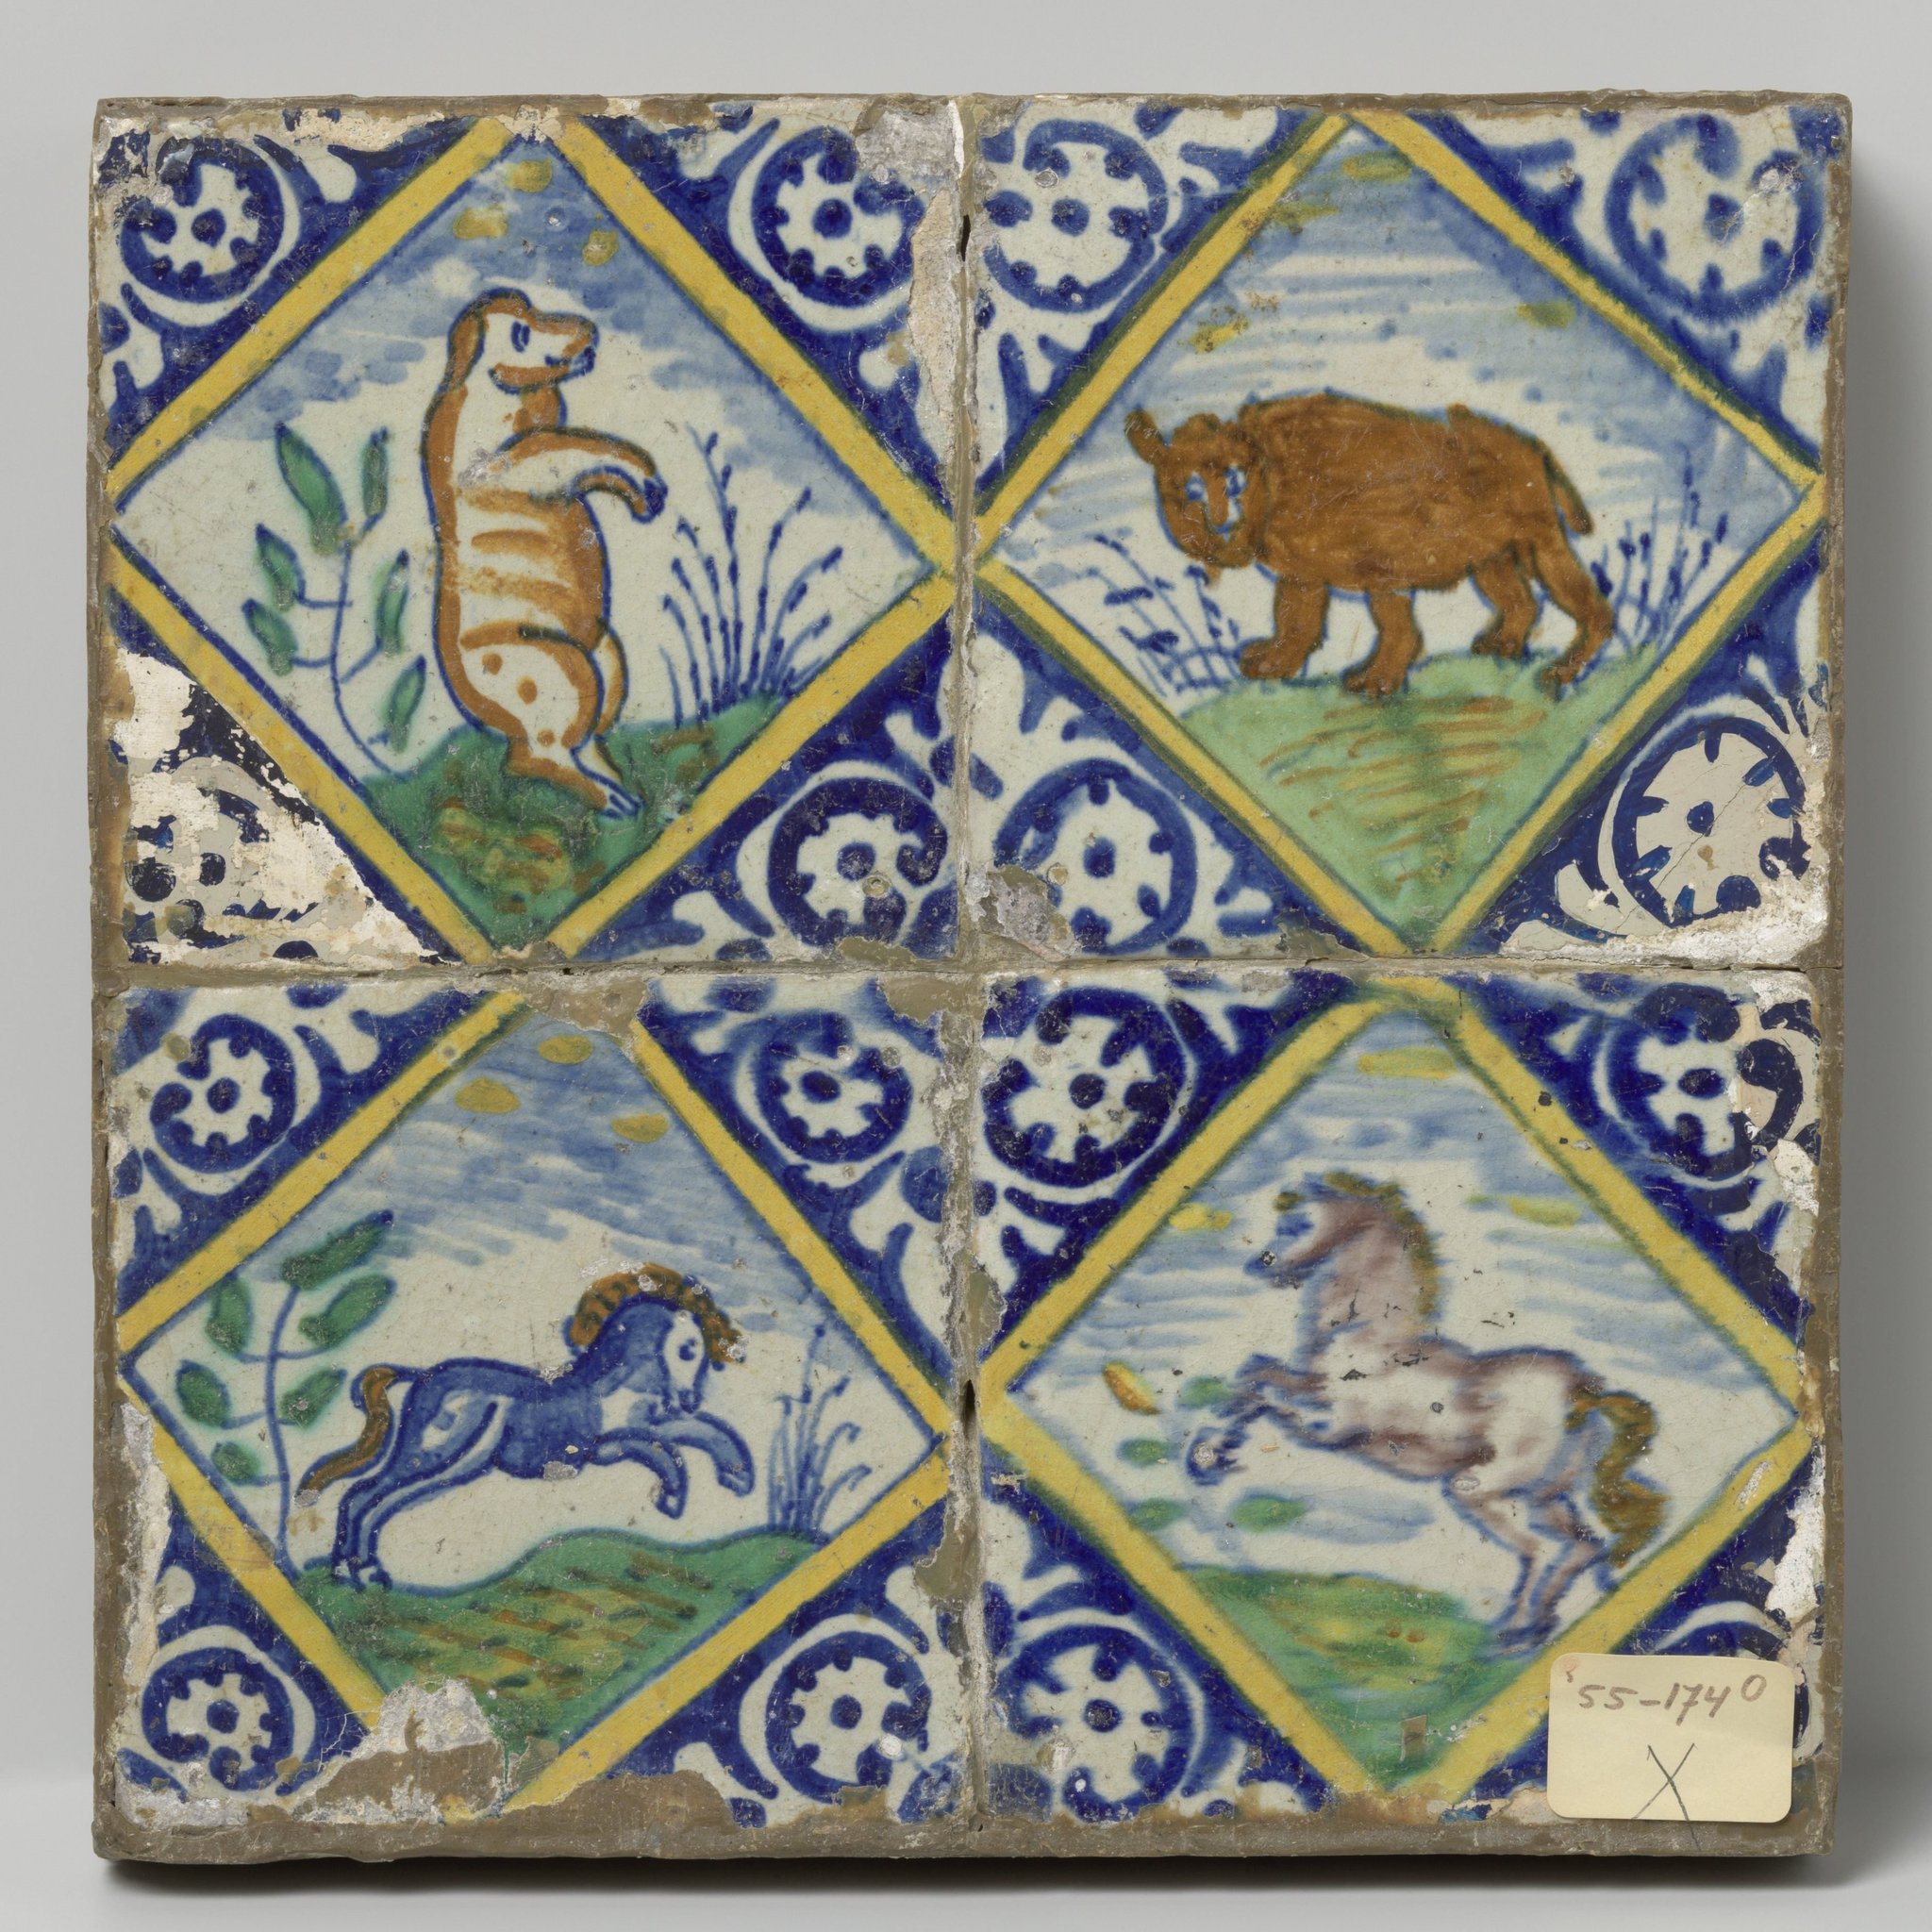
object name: tile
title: Veld van vier tegels met dieren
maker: Anonymous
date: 1580-1625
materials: earthenware, glaze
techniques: maiolica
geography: netherlands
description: Veld van vier tegels (2 x 2) elk met een veelkleurig (blauw, oranje, geel, groen en paars) dier op een grond binnen een kwadraat. In de hoeken, ornament in vultechniek.